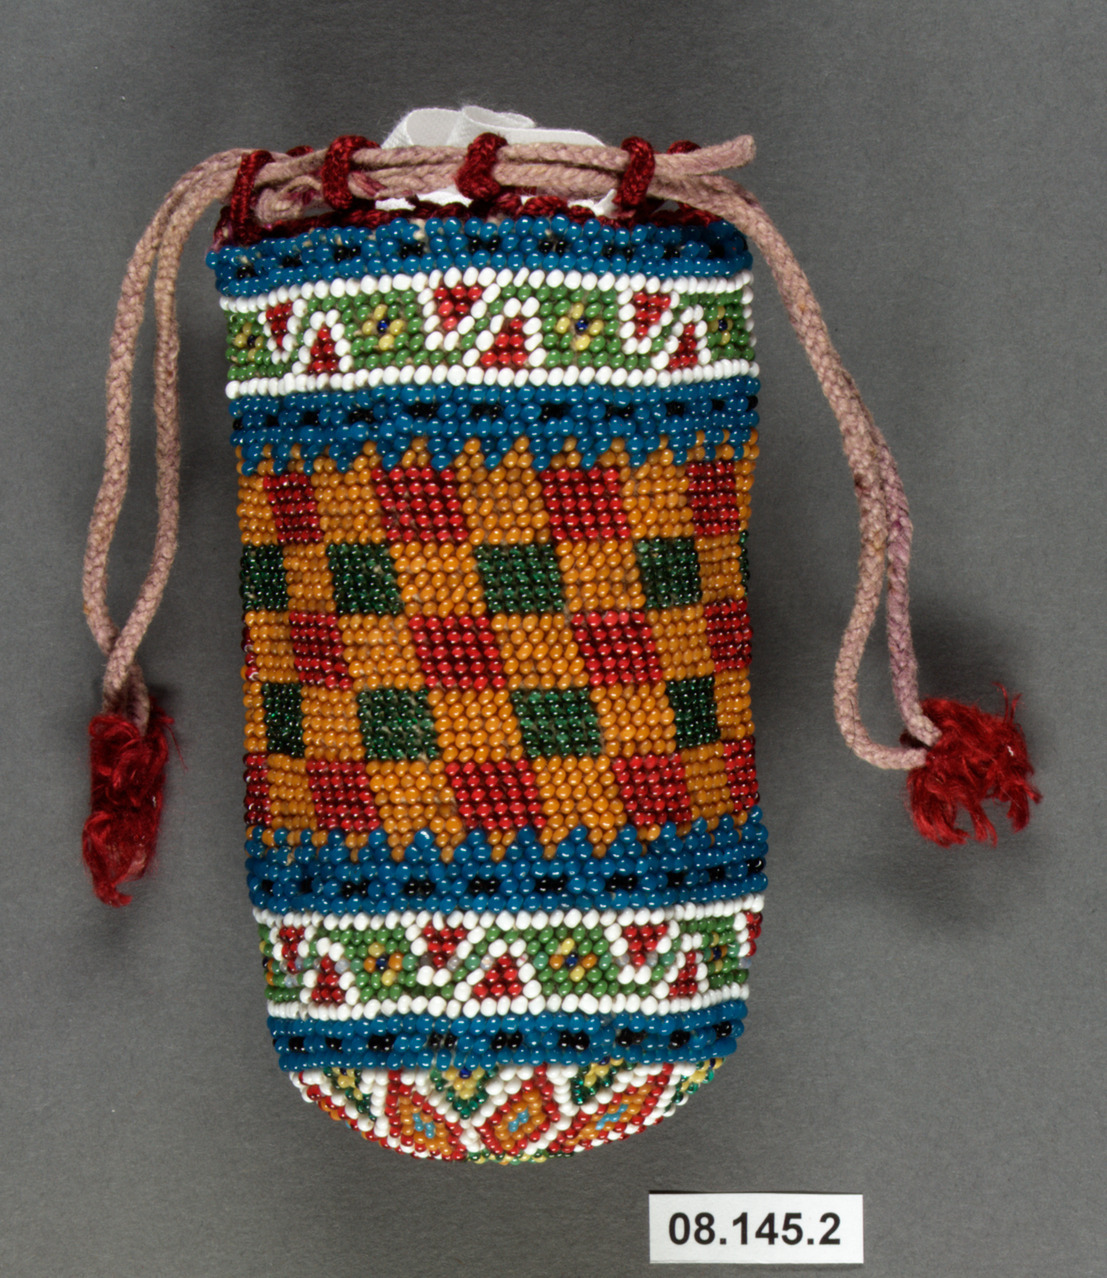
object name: storage bag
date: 1801-1900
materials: glass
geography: iran